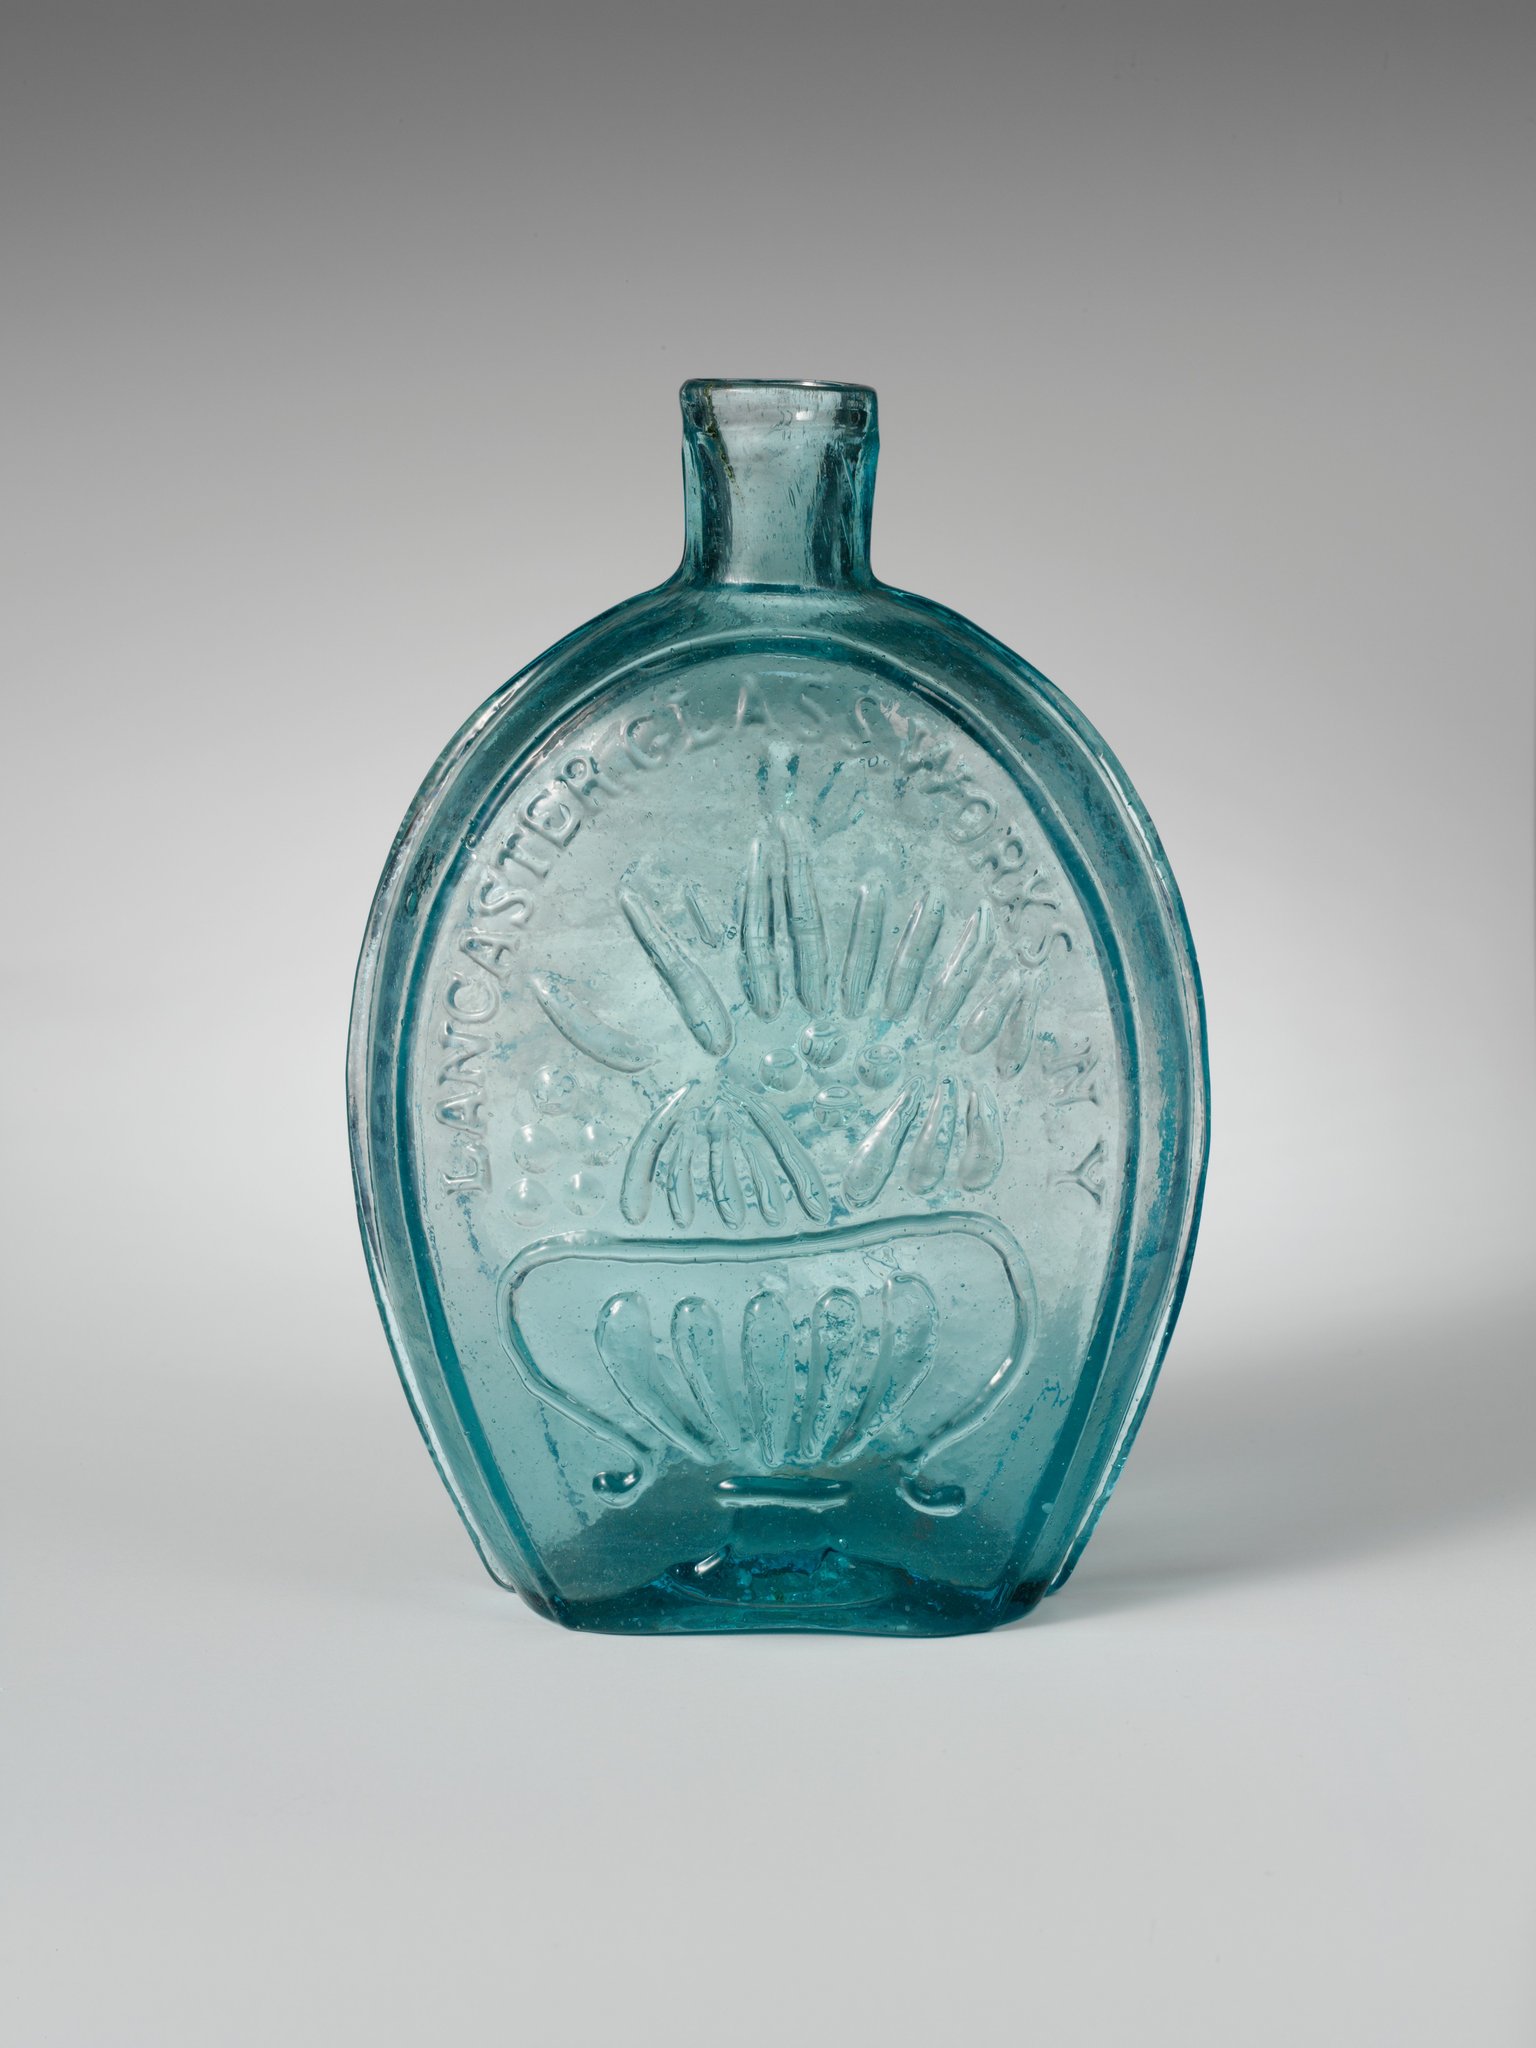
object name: pint flask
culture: american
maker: lancaster glass works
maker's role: maker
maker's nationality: american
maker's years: 1849-1881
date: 1850-1860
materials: gemstone, glass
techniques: glassblowing, molding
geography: united states